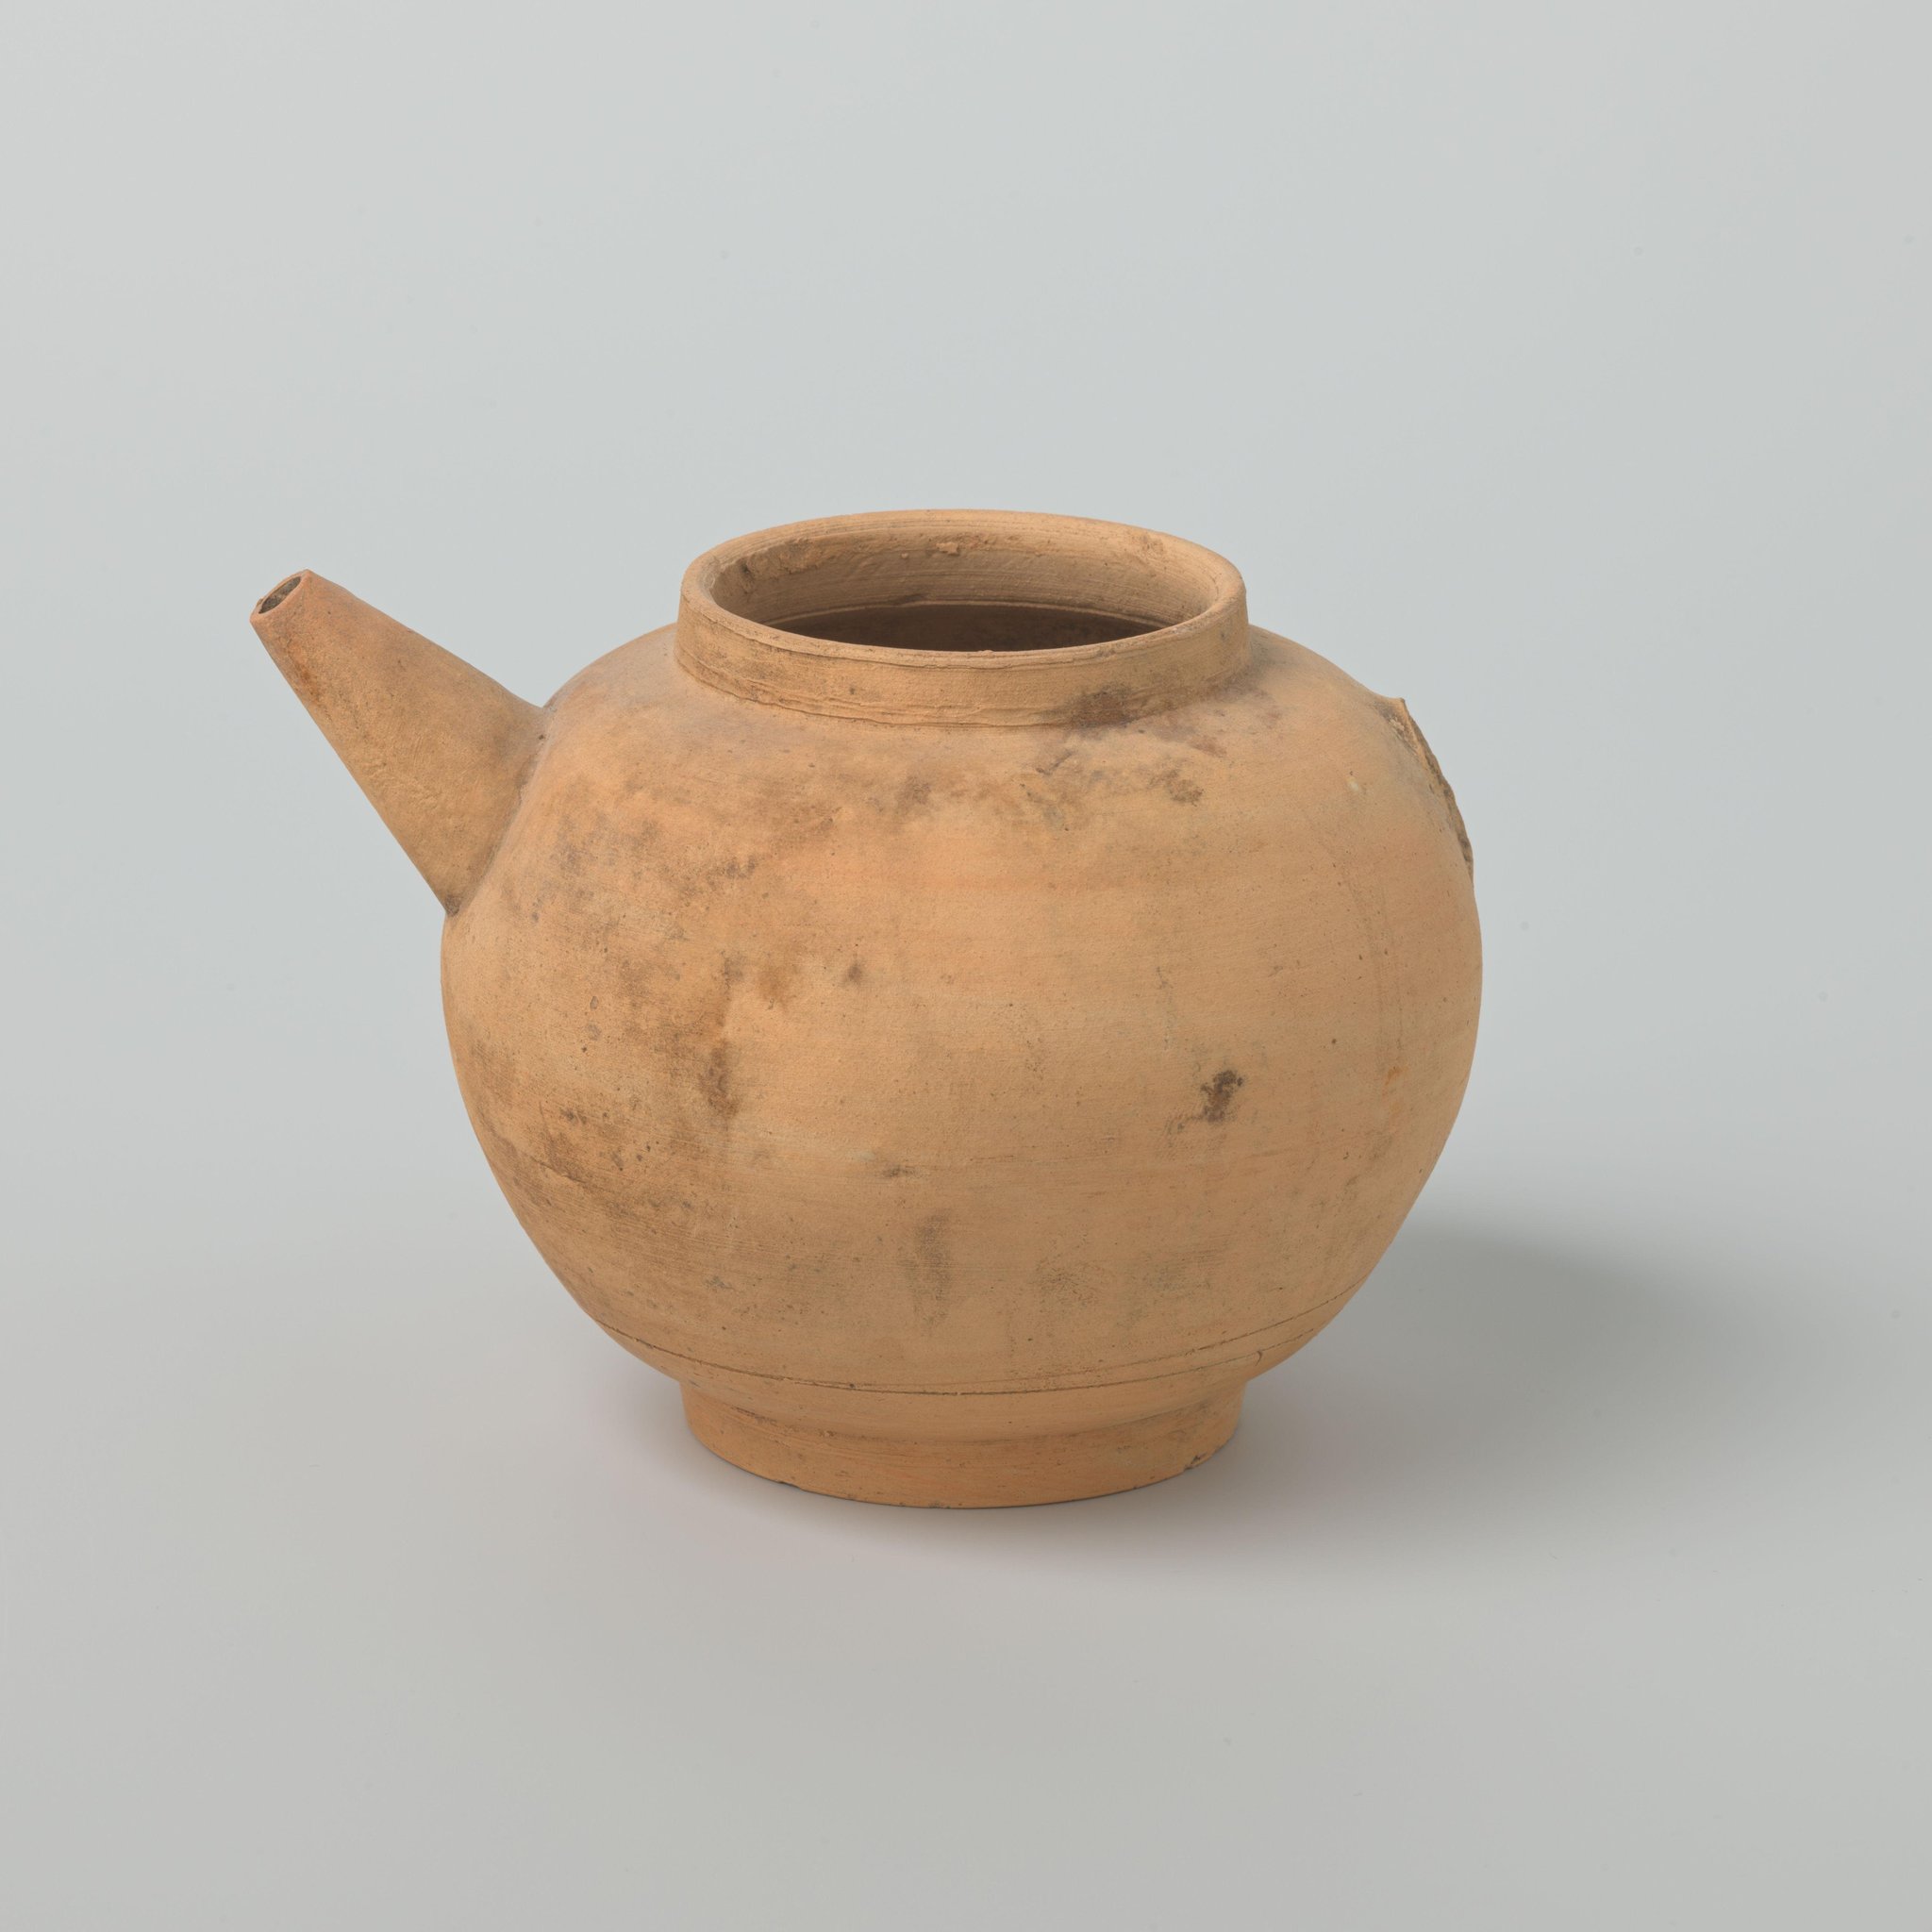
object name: bakafval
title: Theepot van ongeglazuurd aardewerk (De Caluwe bakafval)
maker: jacobus de caluwe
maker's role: plateelbakkerij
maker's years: -1730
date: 1700-1725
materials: earthenware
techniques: firing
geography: delft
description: Toegeschreven aan Jacobus de Caluwe, omdat dit voorwerp samen met gemerkte stukken (‘Jacobus De Caluwe’ en rennend hert) gevonden is op de plaats waar zich De Caluwes tweede werkplaats bevond. Er is een duidelijke stilistische overeenkomst tussen de gemerkte en niet gemerkte voorwerpen uit deze archeologische vondst.